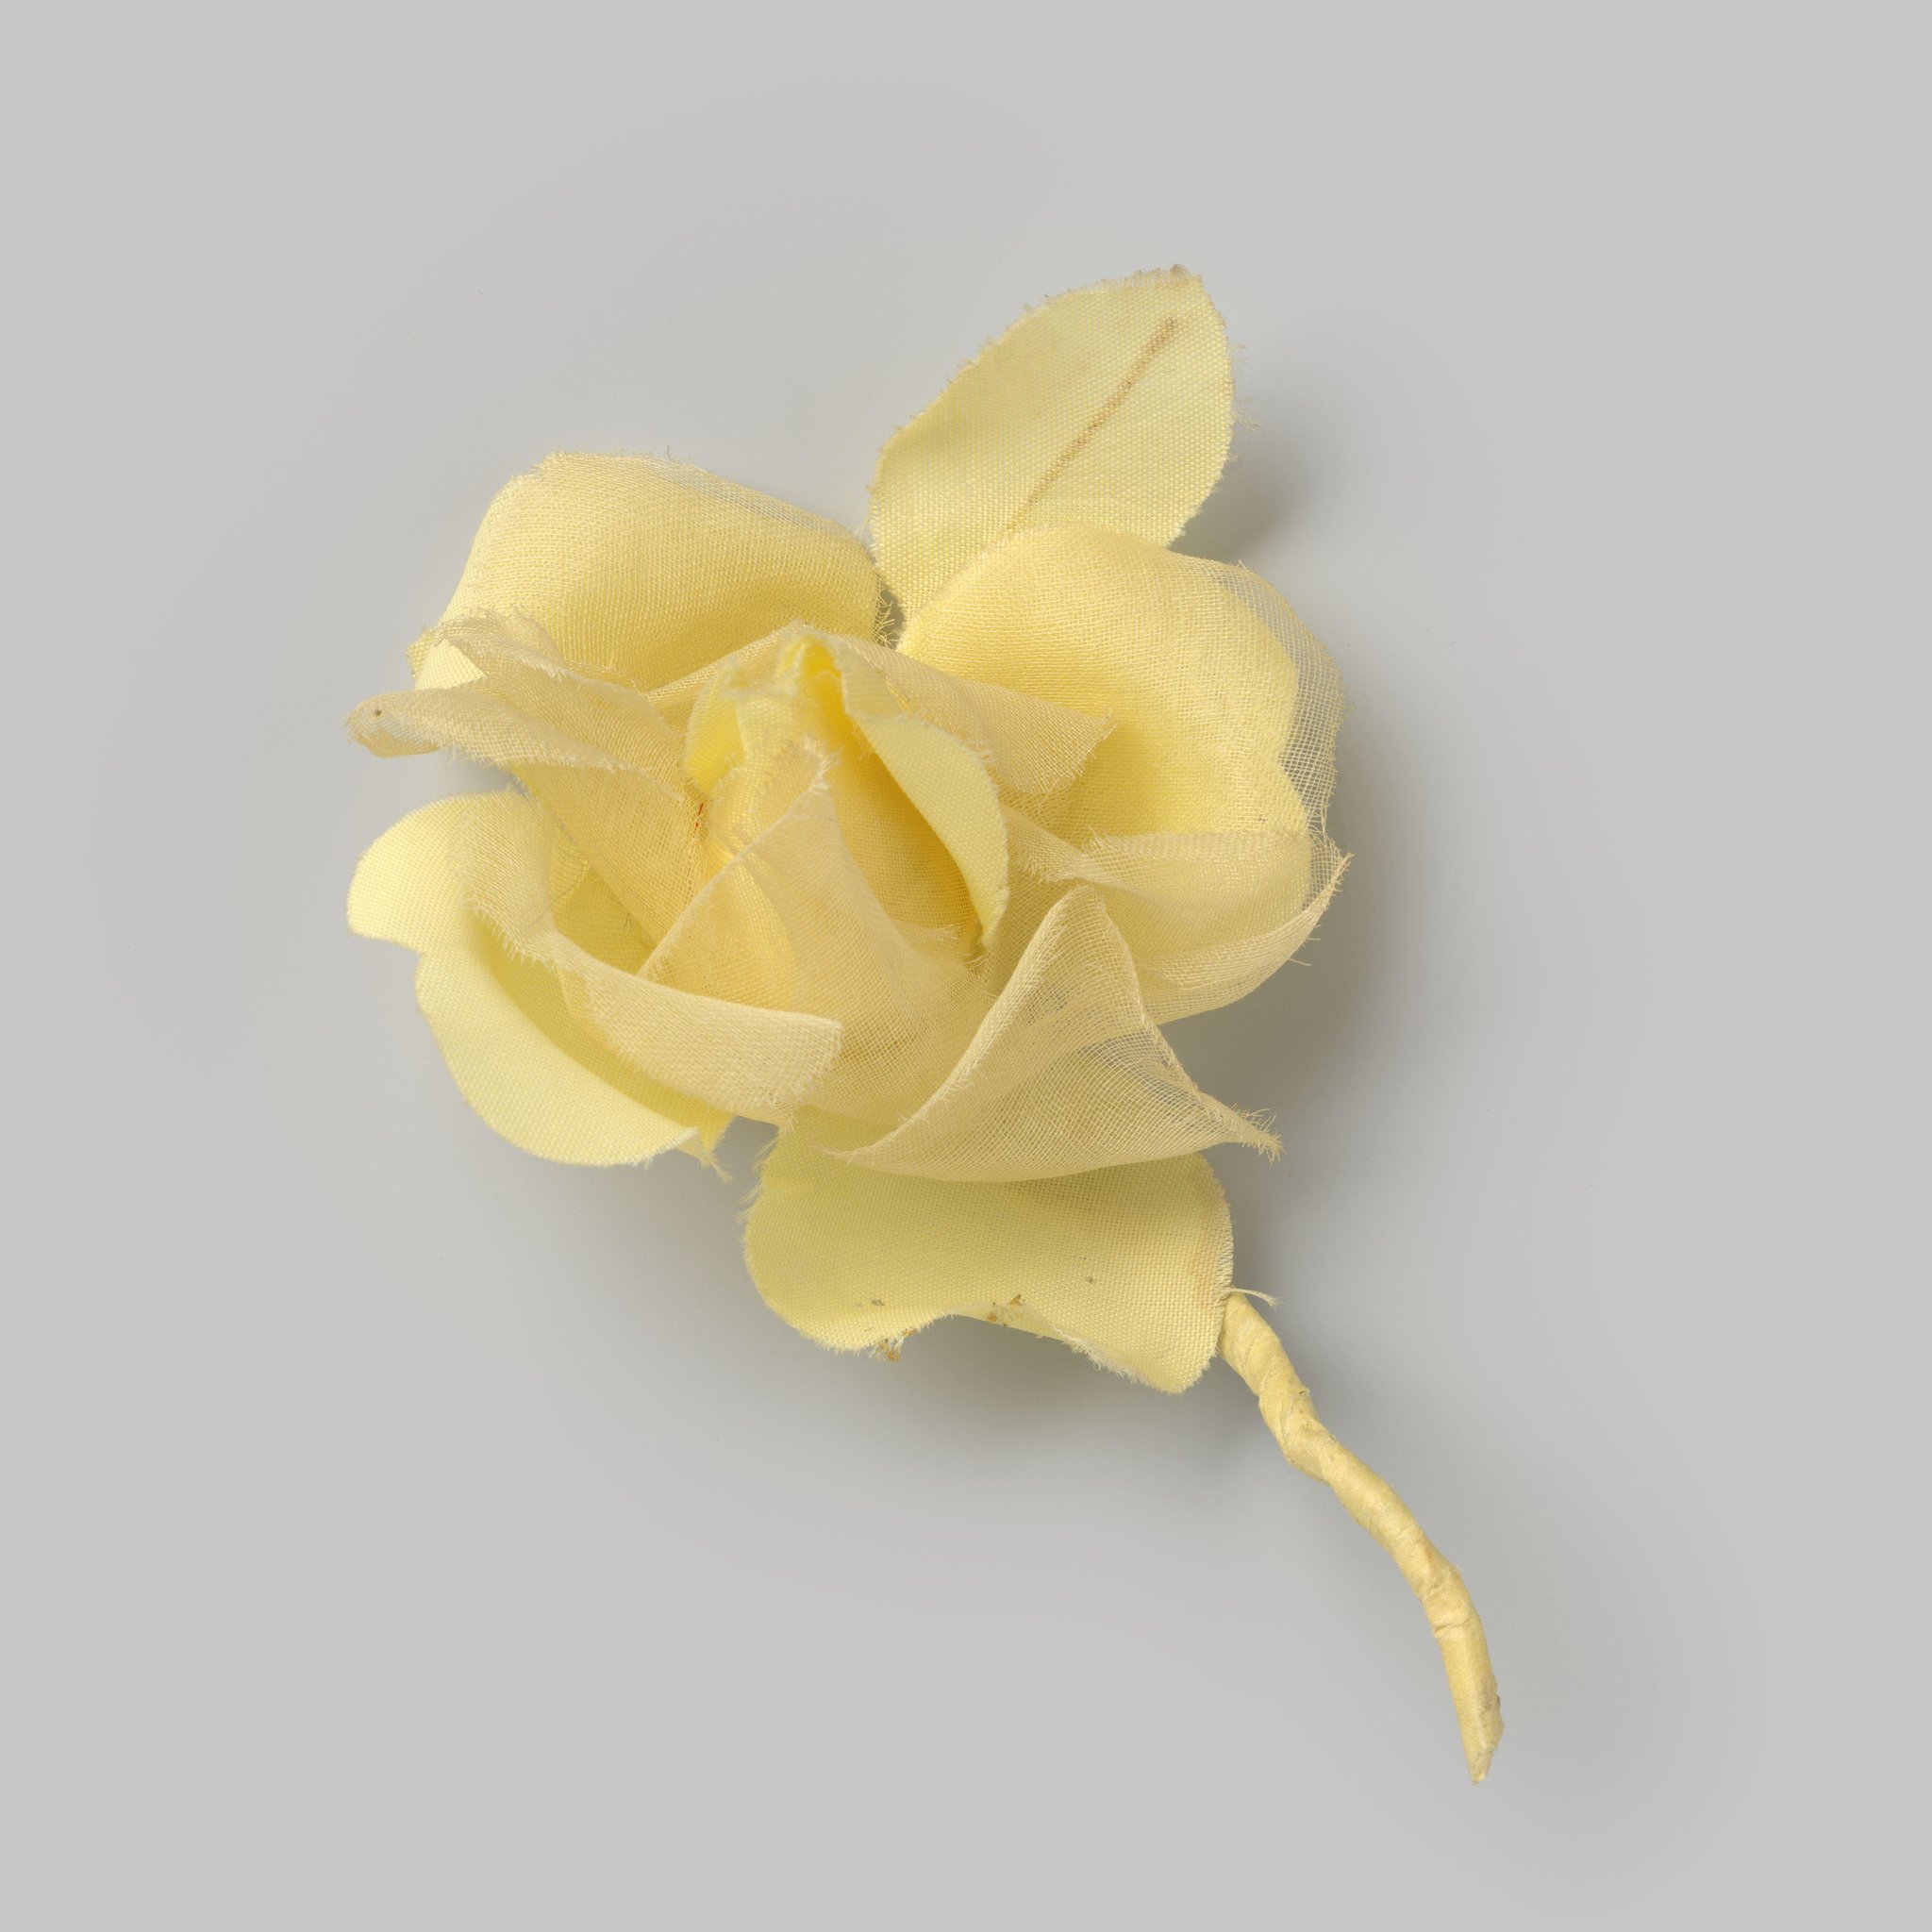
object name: corsage costume accessory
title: Corsage in de vorm van een gele roos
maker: Anonymous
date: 1900-1950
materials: textile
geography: europe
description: Verzameling cortages, vier van stof, één van kunststof. B. Gele roos.